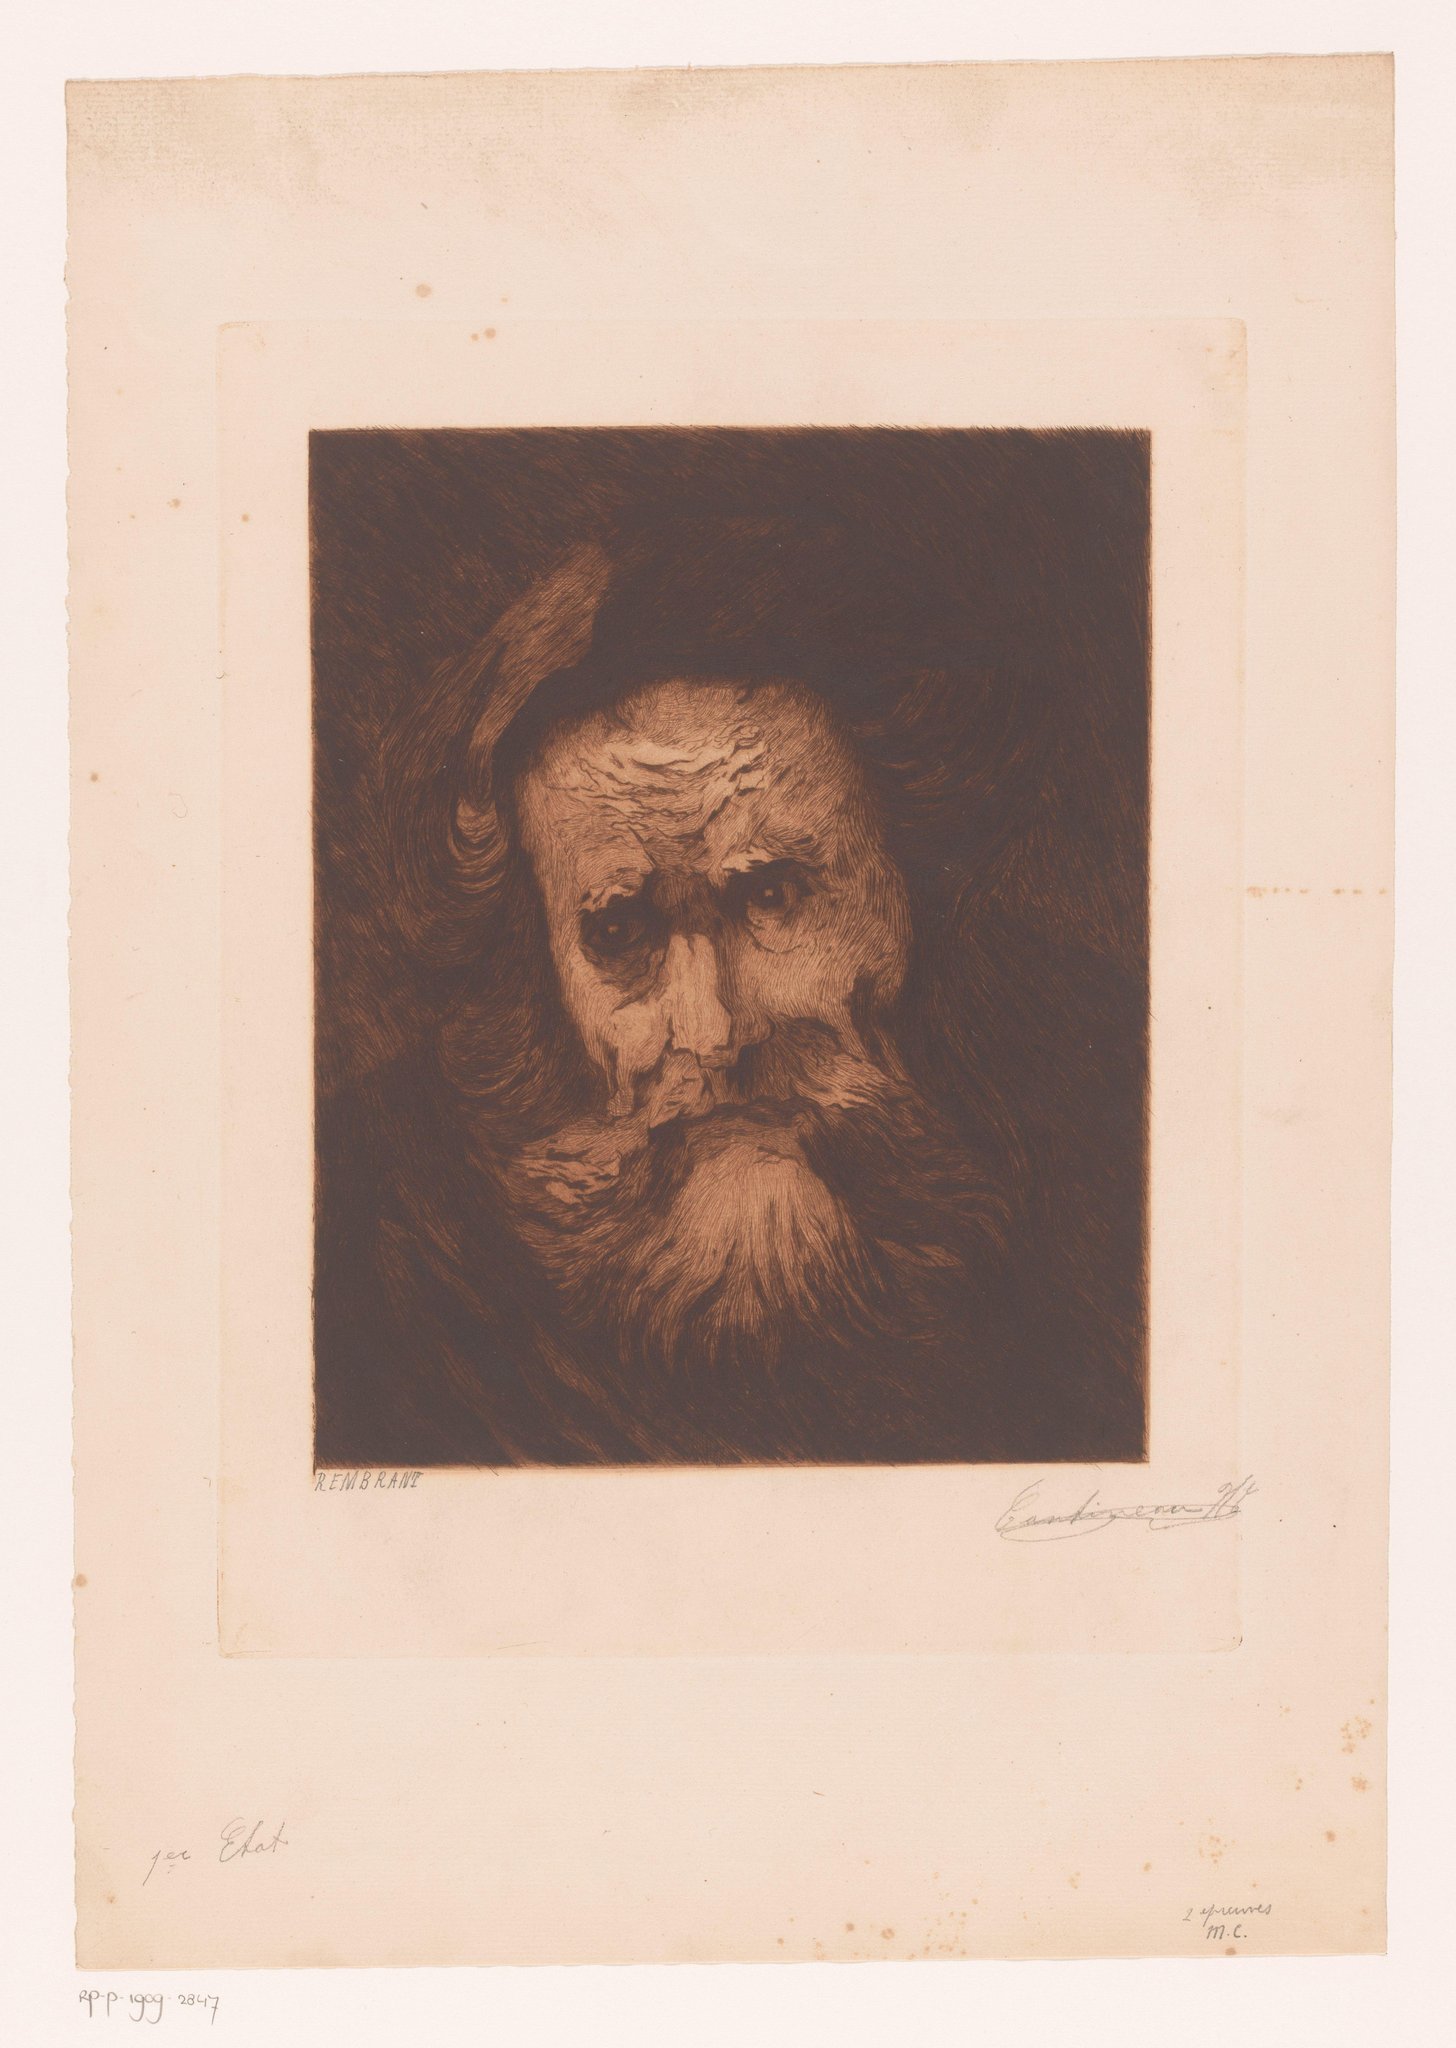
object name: print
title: Kop van een grijsaard met baard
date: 1885-1909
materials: paper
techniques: drypoint, etching, intaglio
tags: leiden, amsterdam, painter, print maker, draughtsman, rembrandt van rijn, portrait, self-portrait of artist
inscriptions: annotation: ‘2 epreuves M.C.’, annotation: ‘1er état’, collector's mark: Lugt 2228, annotation: ‘6 tete d'apres Rembrant par Cantineau’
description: Sterfdatum prentmaker onbekend. Derhalve is voor bepaling van de rechten van dit object de verwervingsdatum aangehouden.